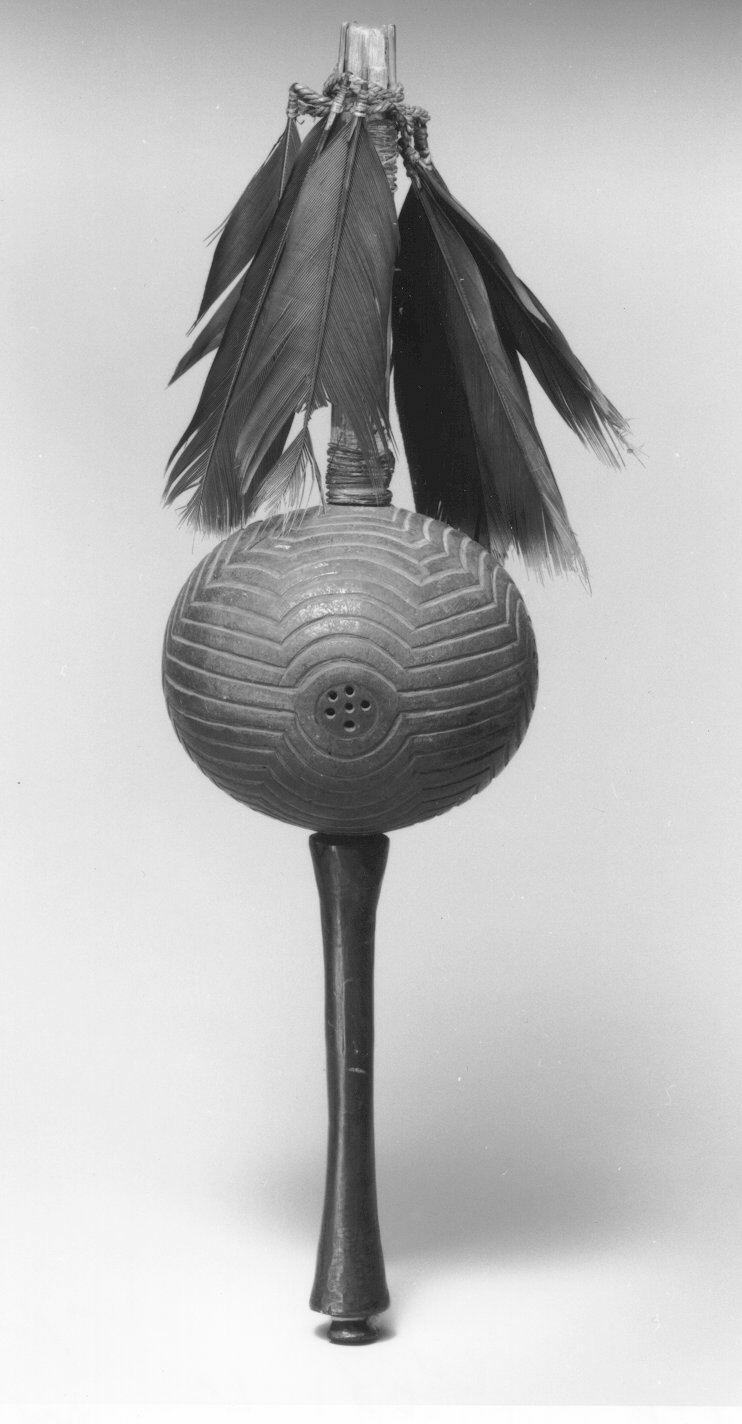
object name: tsiitsiito rattle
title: Tsiitsiito (rattle)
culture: hiwi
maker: hiwi indians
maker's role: culture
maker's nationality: native american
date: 1867-1900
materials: feather, stone, wood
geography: colombia